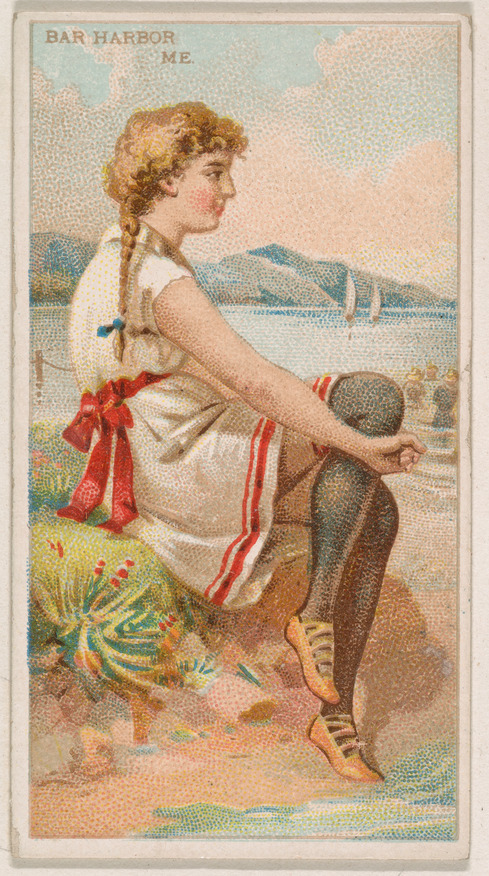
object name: print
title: Bar Harbor, Maine, from the Surf Beauties series (N232), issued by Kinney Bros.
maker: kinney brothers tobacco company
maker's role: publisher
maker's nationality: american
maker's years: 1869-2011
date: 1889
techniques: color lithograph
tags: girls,profiles